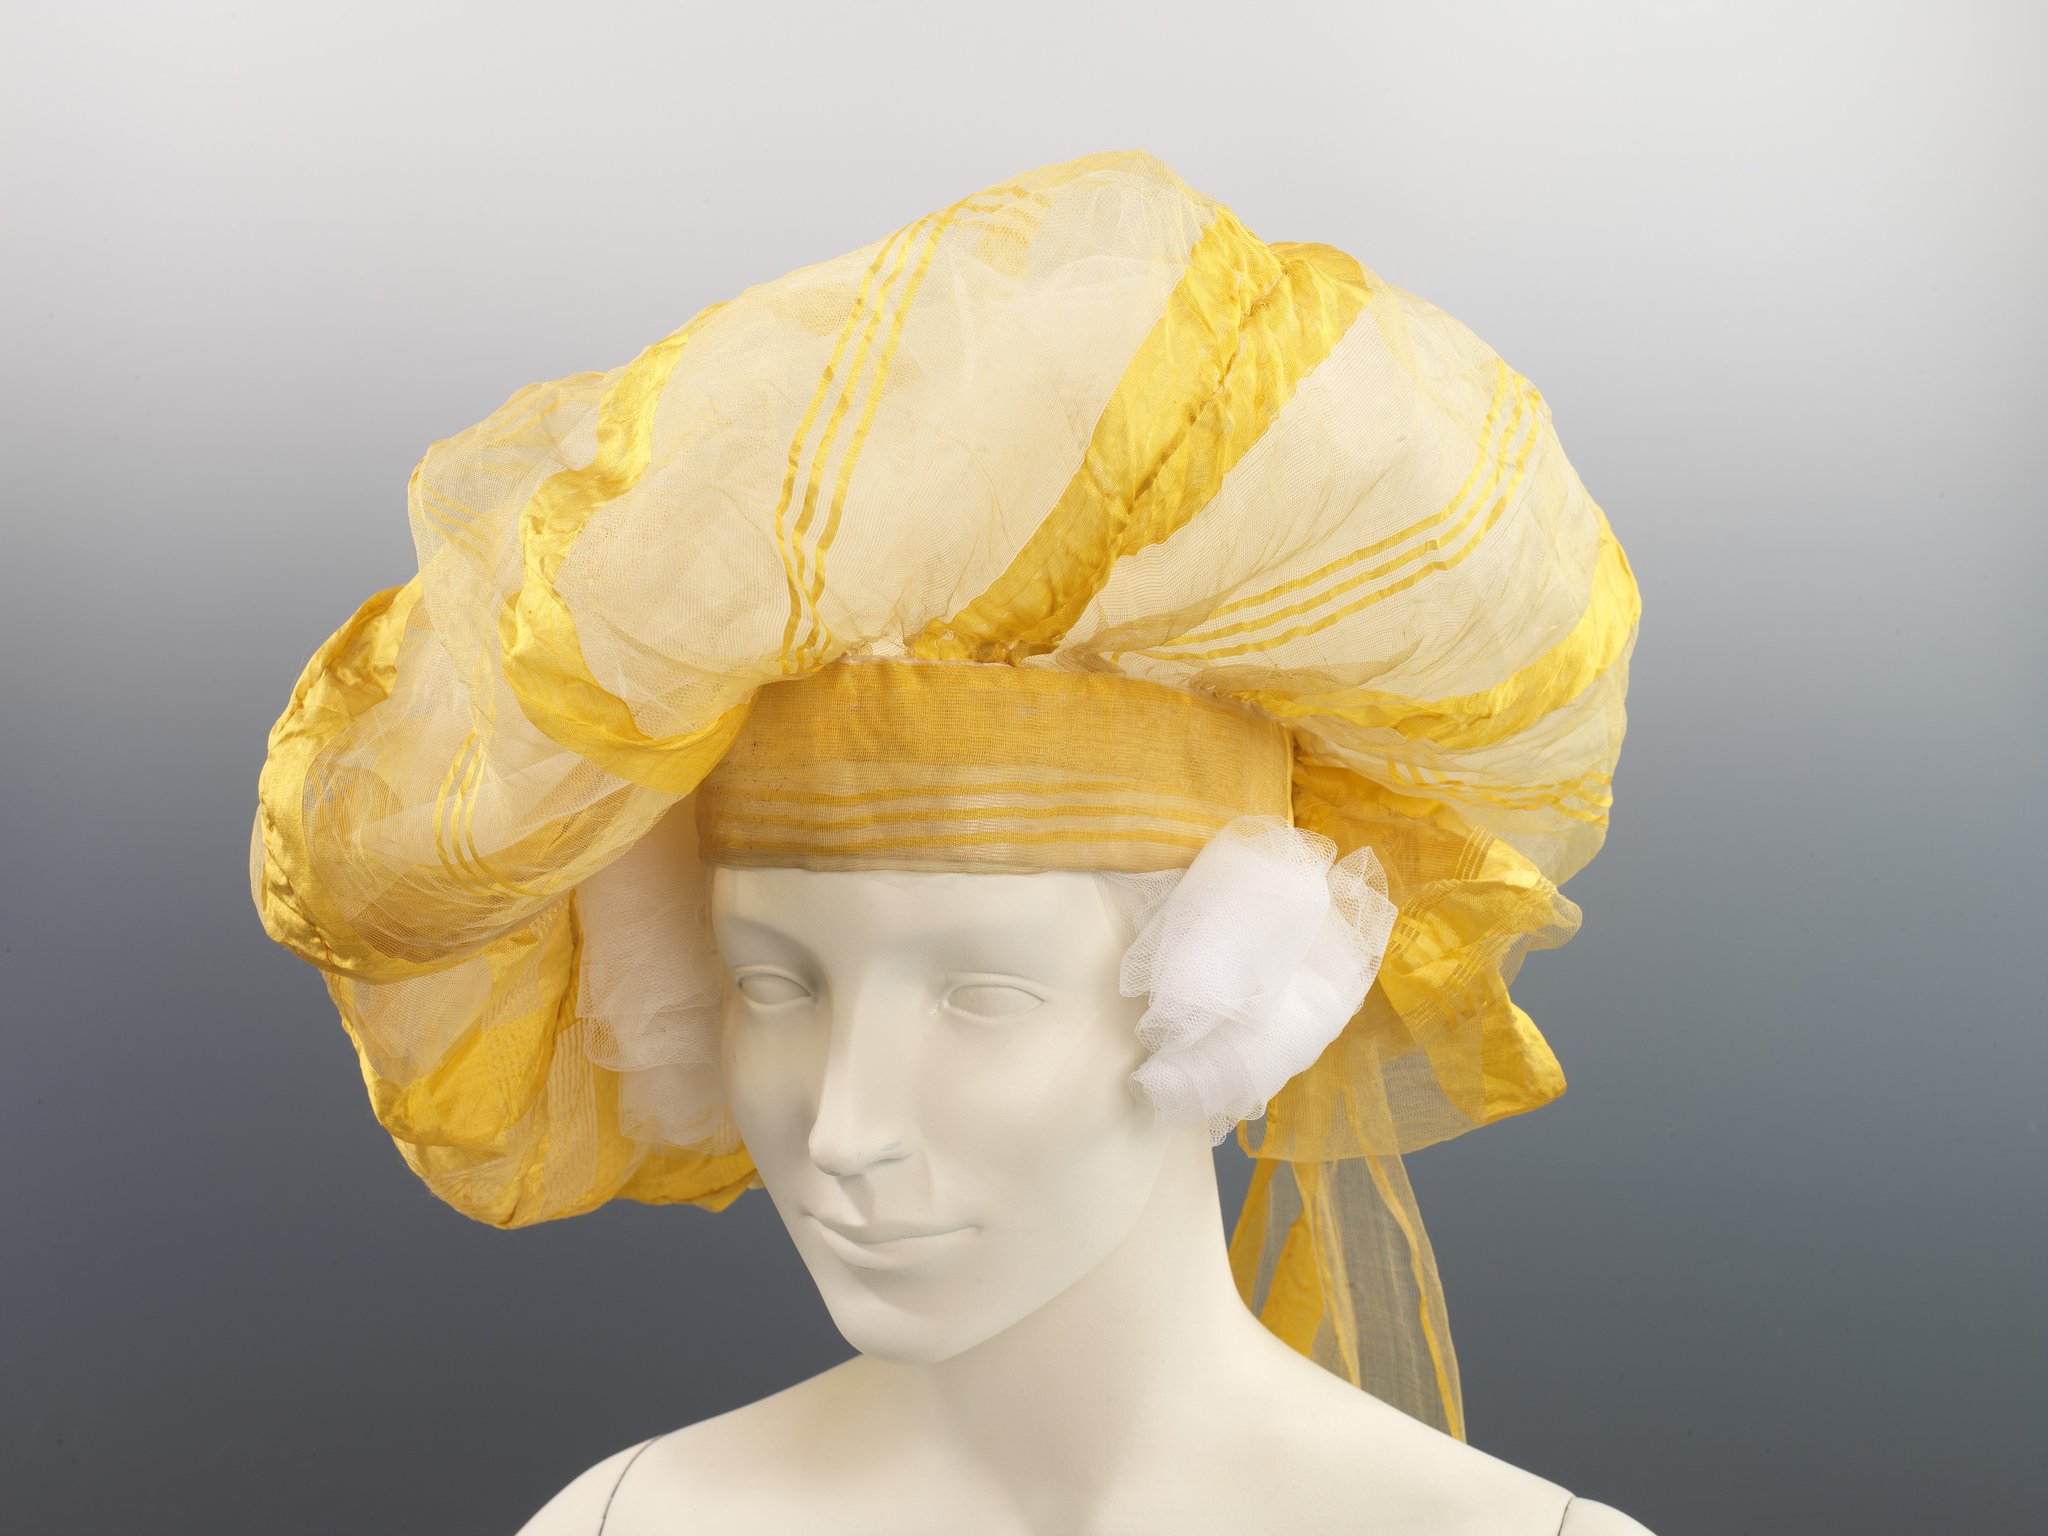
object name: turban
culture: british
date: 1820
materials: silk